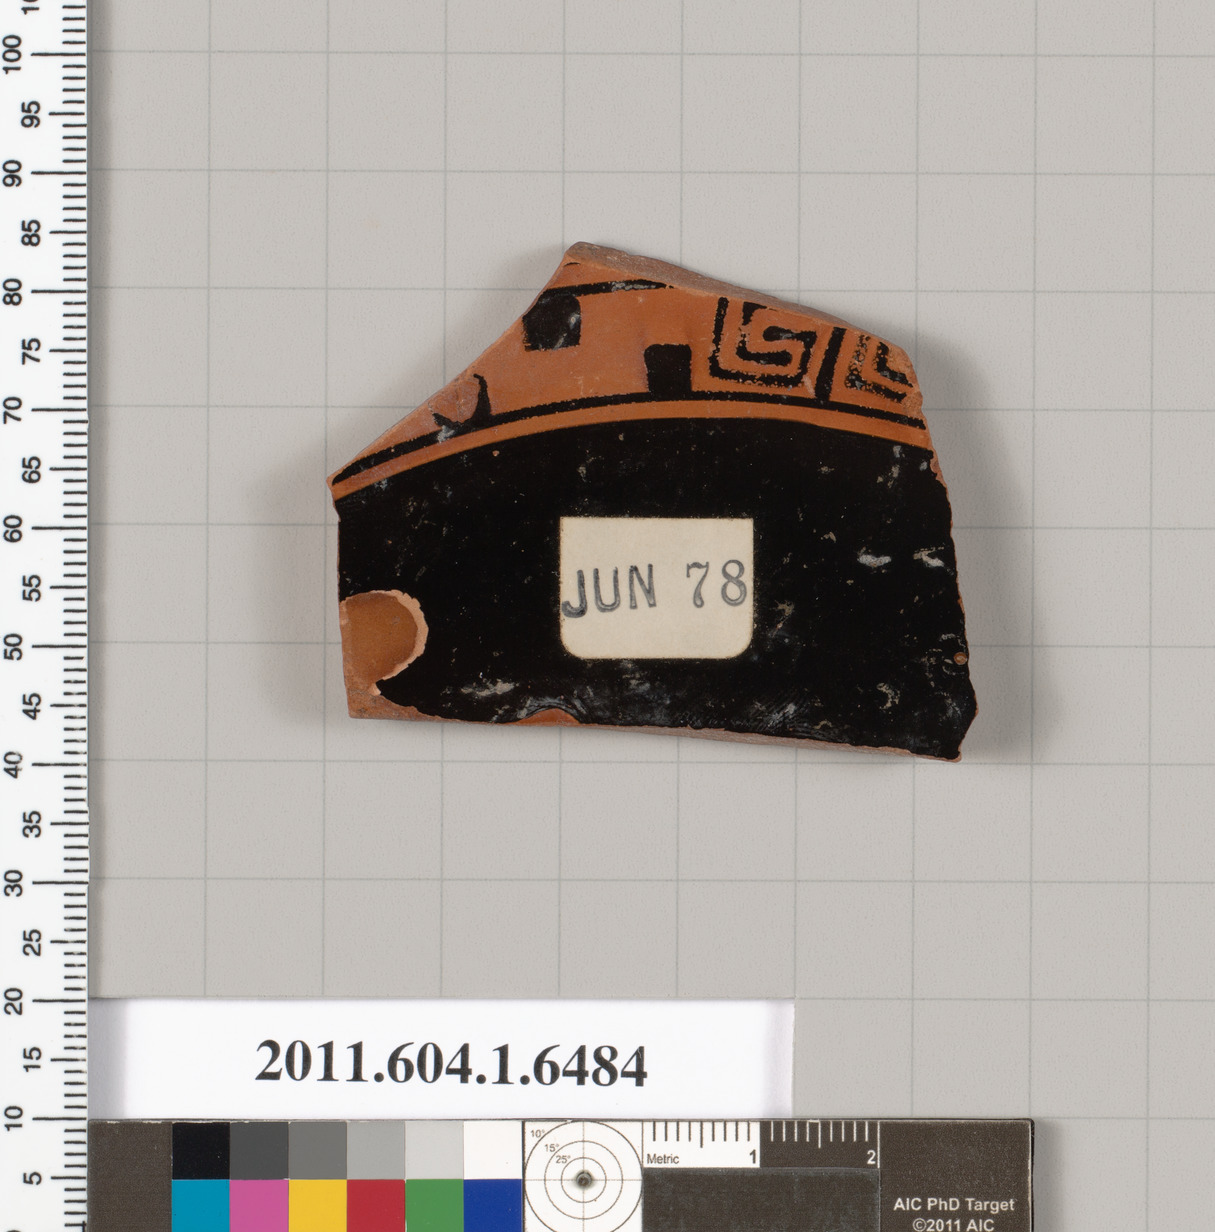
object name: kylix fragment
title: Terracotta fragment of a kylix (drinking cup)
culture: greek, attic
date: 490-480 BCE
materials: terracotta